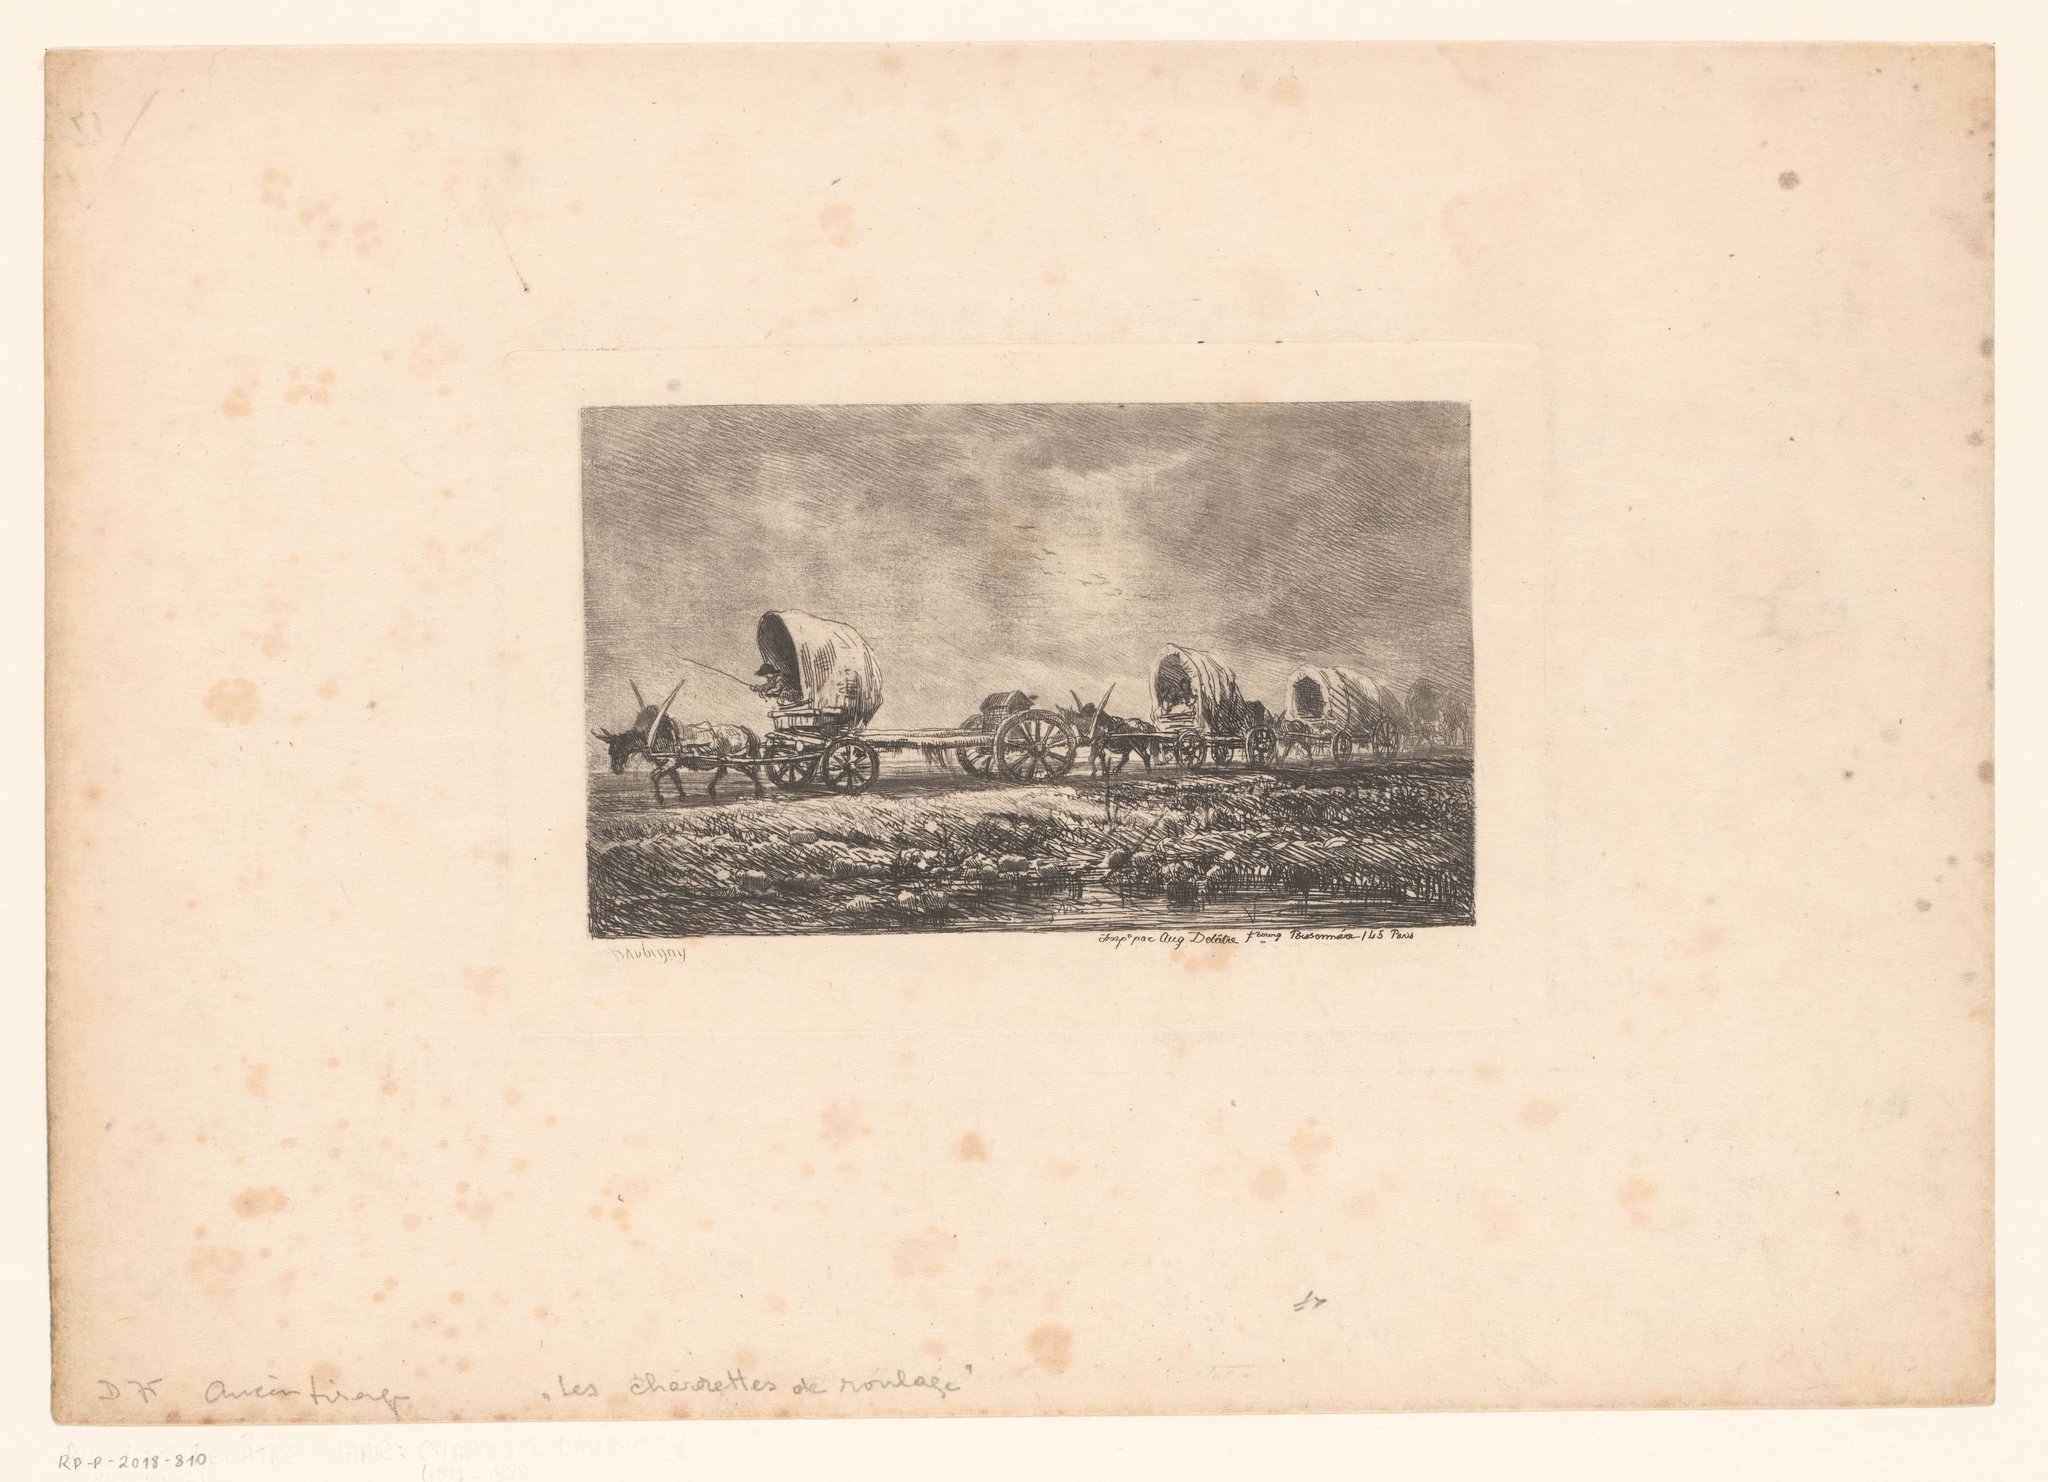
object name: print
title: Serie etsen van landschappen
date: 1850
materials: paper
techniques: engraving, etching, roulette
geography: paris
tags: landscapes, covered wagon, hooded wagon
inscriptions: collector's mark: Lugt 2228